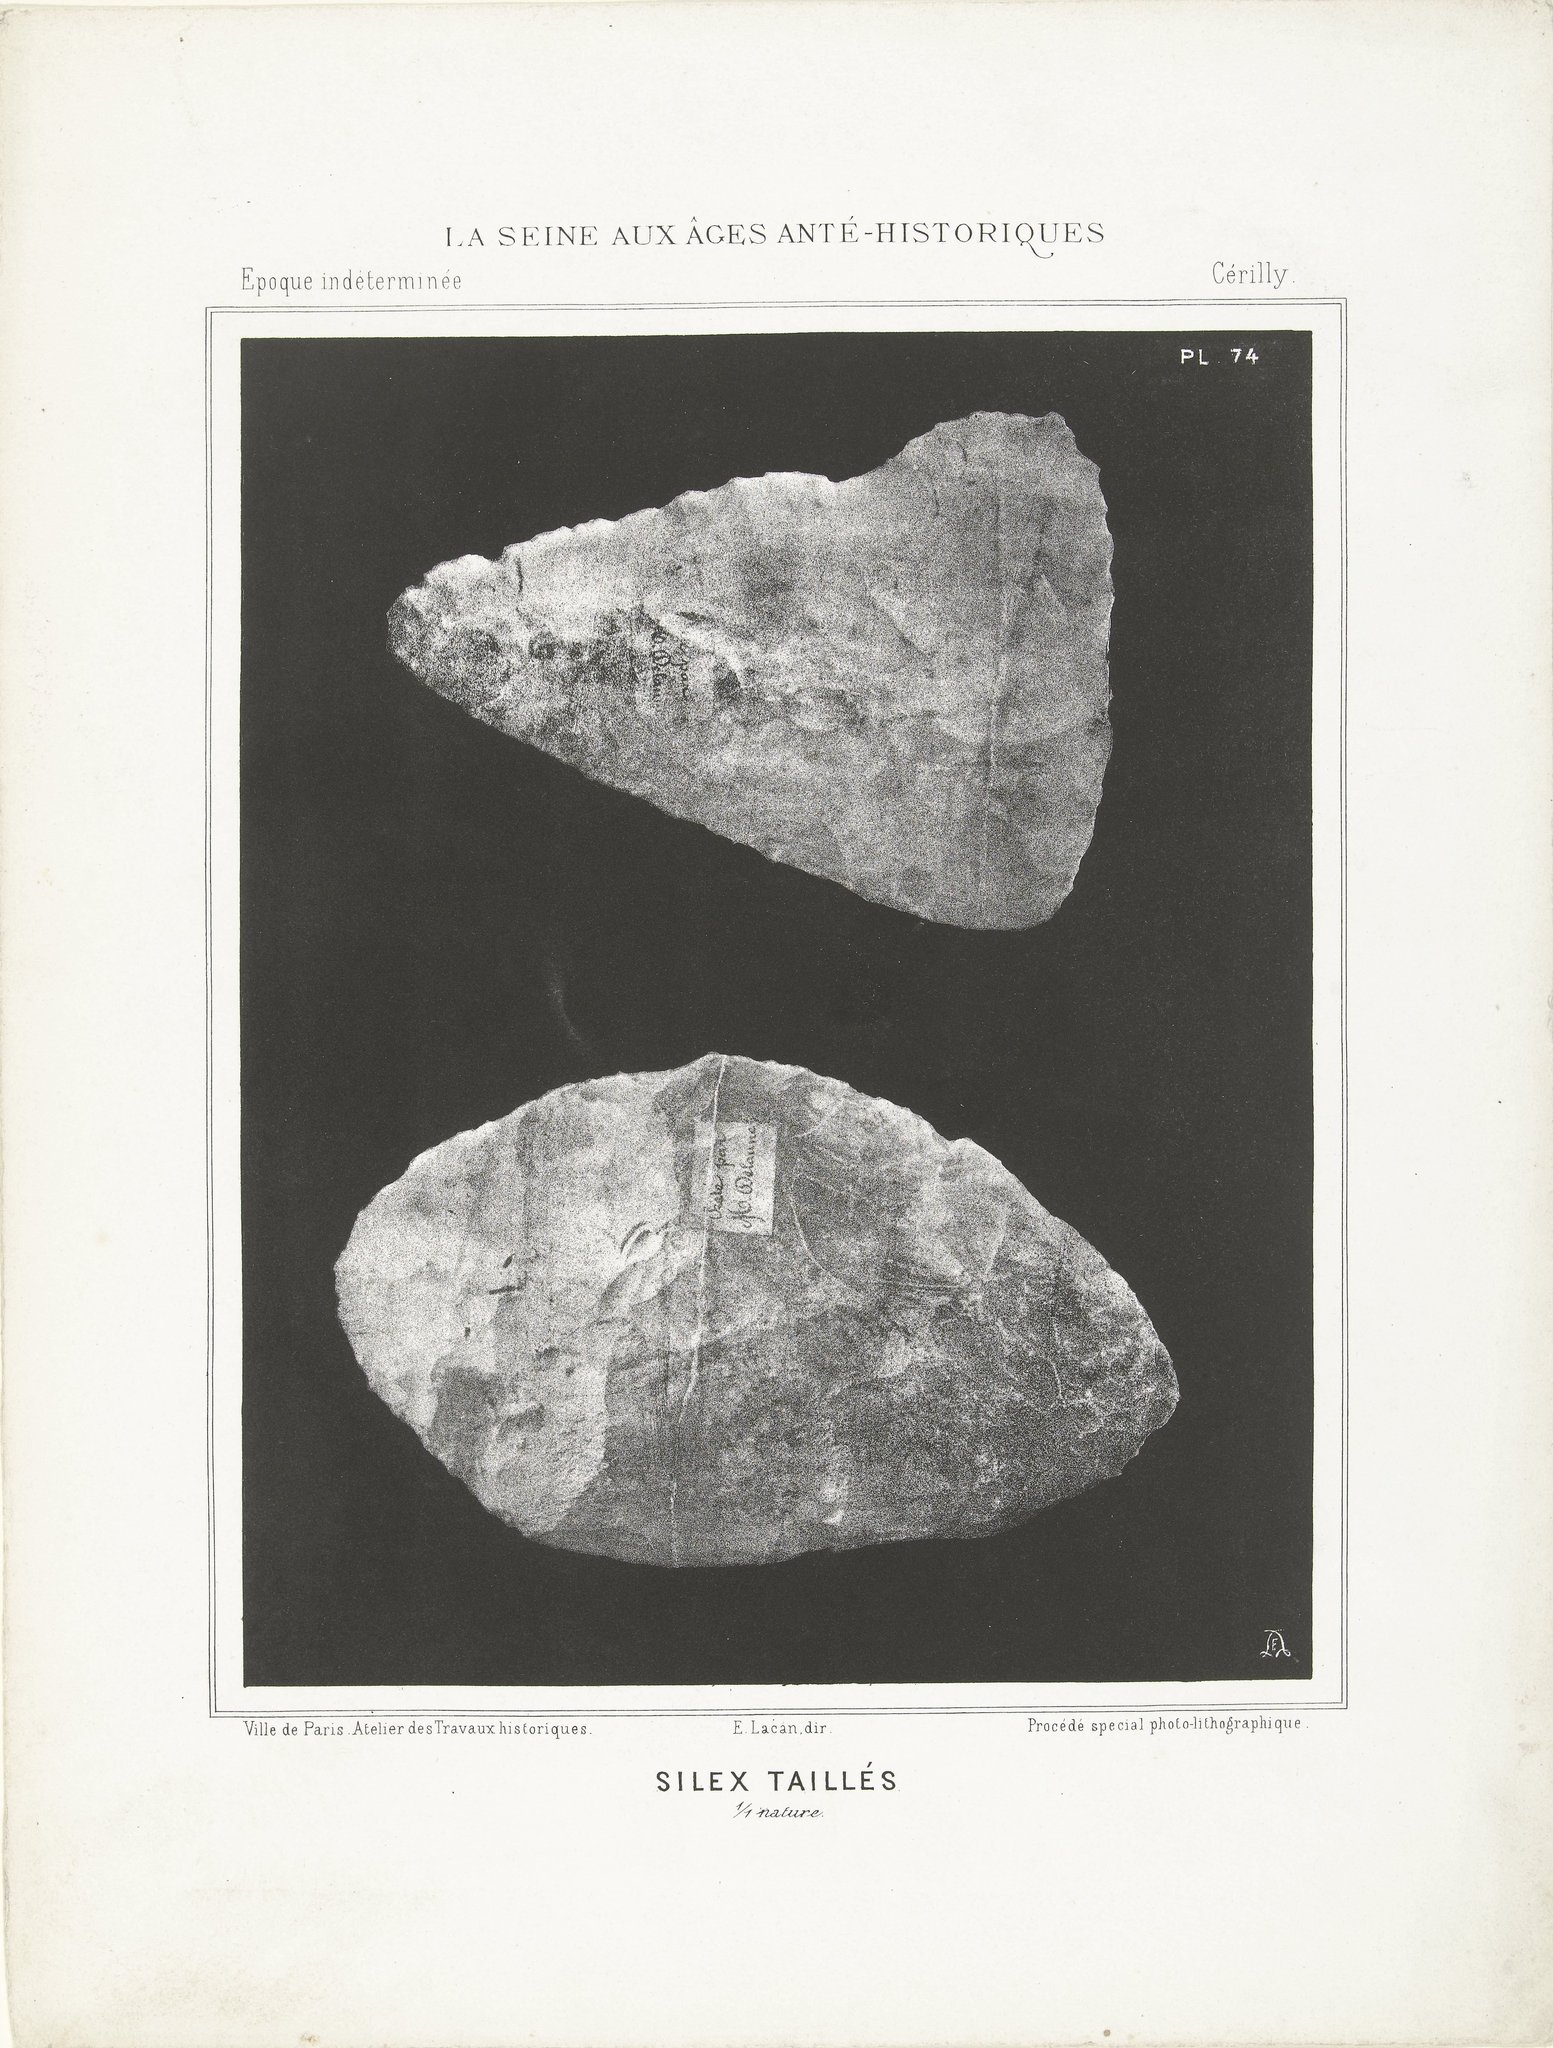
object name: photomechanical print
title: Silex taillés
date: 1869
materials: paper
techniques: photolithography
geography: paris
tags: tools, aids, implements ~ crafts and industries, kinds of non-precious stone: flint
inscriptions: inscription: ‘Epoque indéterminée Cérilly/ PL 74’, inscription: ‘Ville de Paris. Atelier des Travaux historiques. E. Lacan, dir. Procédé spécial photo-lithographique./ Silex taillés/ 1/1 nature.’